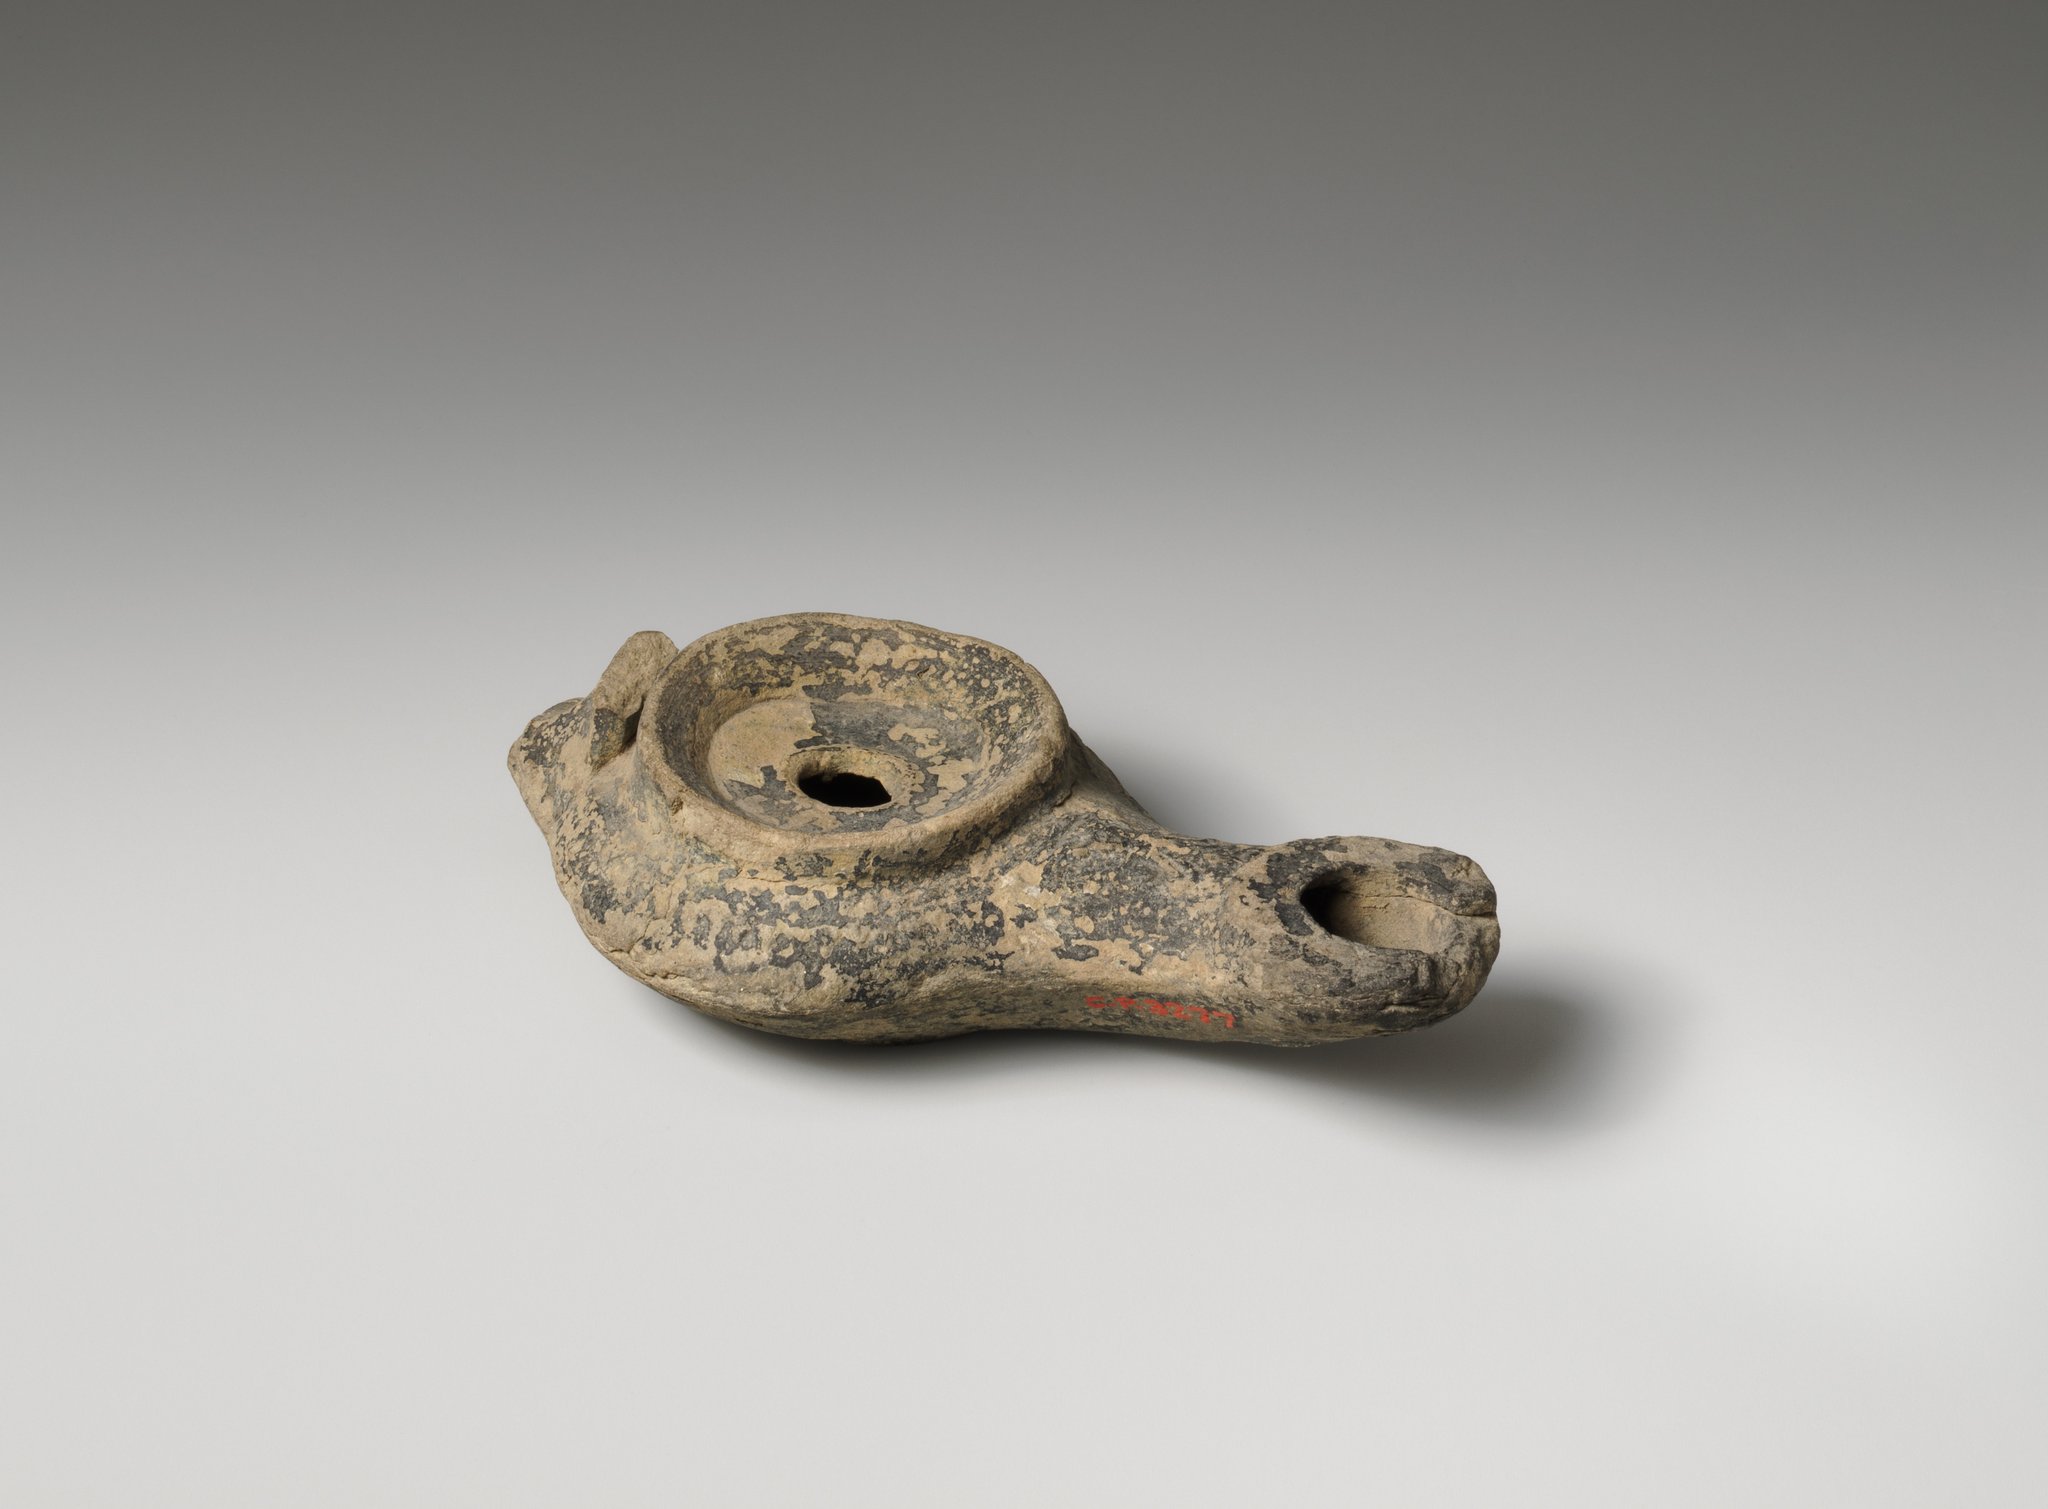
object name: lamp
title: Terracotta oil lamp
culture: greek or roman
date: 100 BCE-100 CE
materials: terracotta